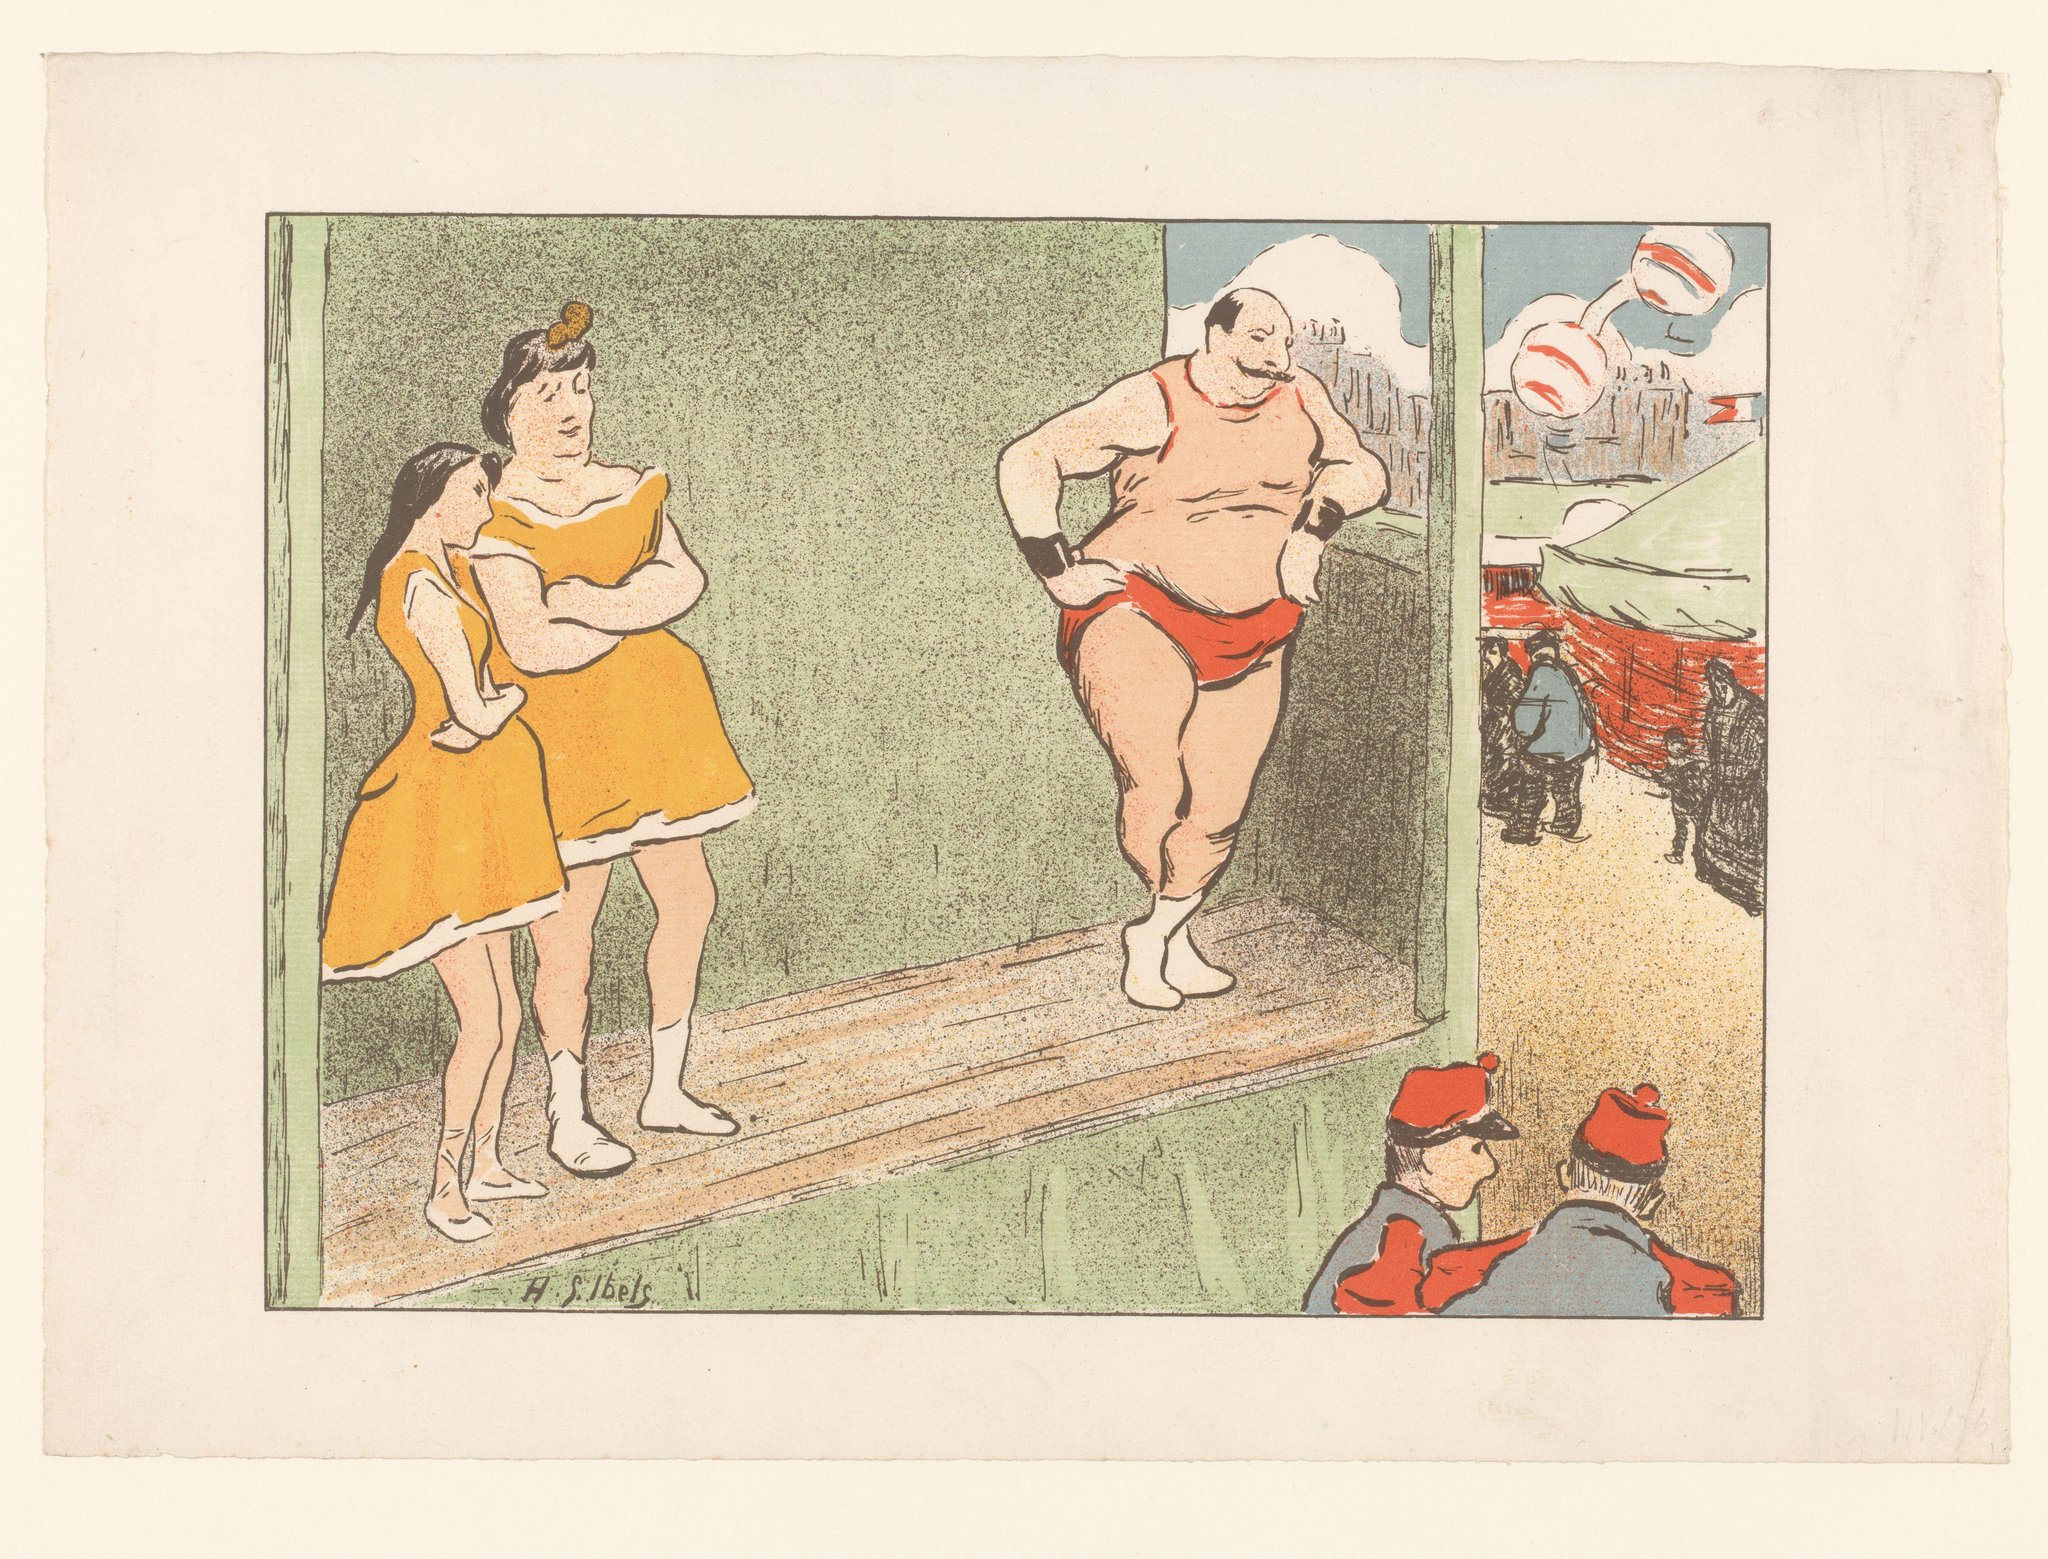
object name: print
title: Les Programmes du Théâtre Libre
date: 1892-1893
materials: paper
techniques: lithograph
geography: paris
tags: group of actors, troupe; actors on the stage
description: Ontwerp voor de programma's van de voorstellingen Le Grappin en L'Affranchie van het Théâtre Libre.